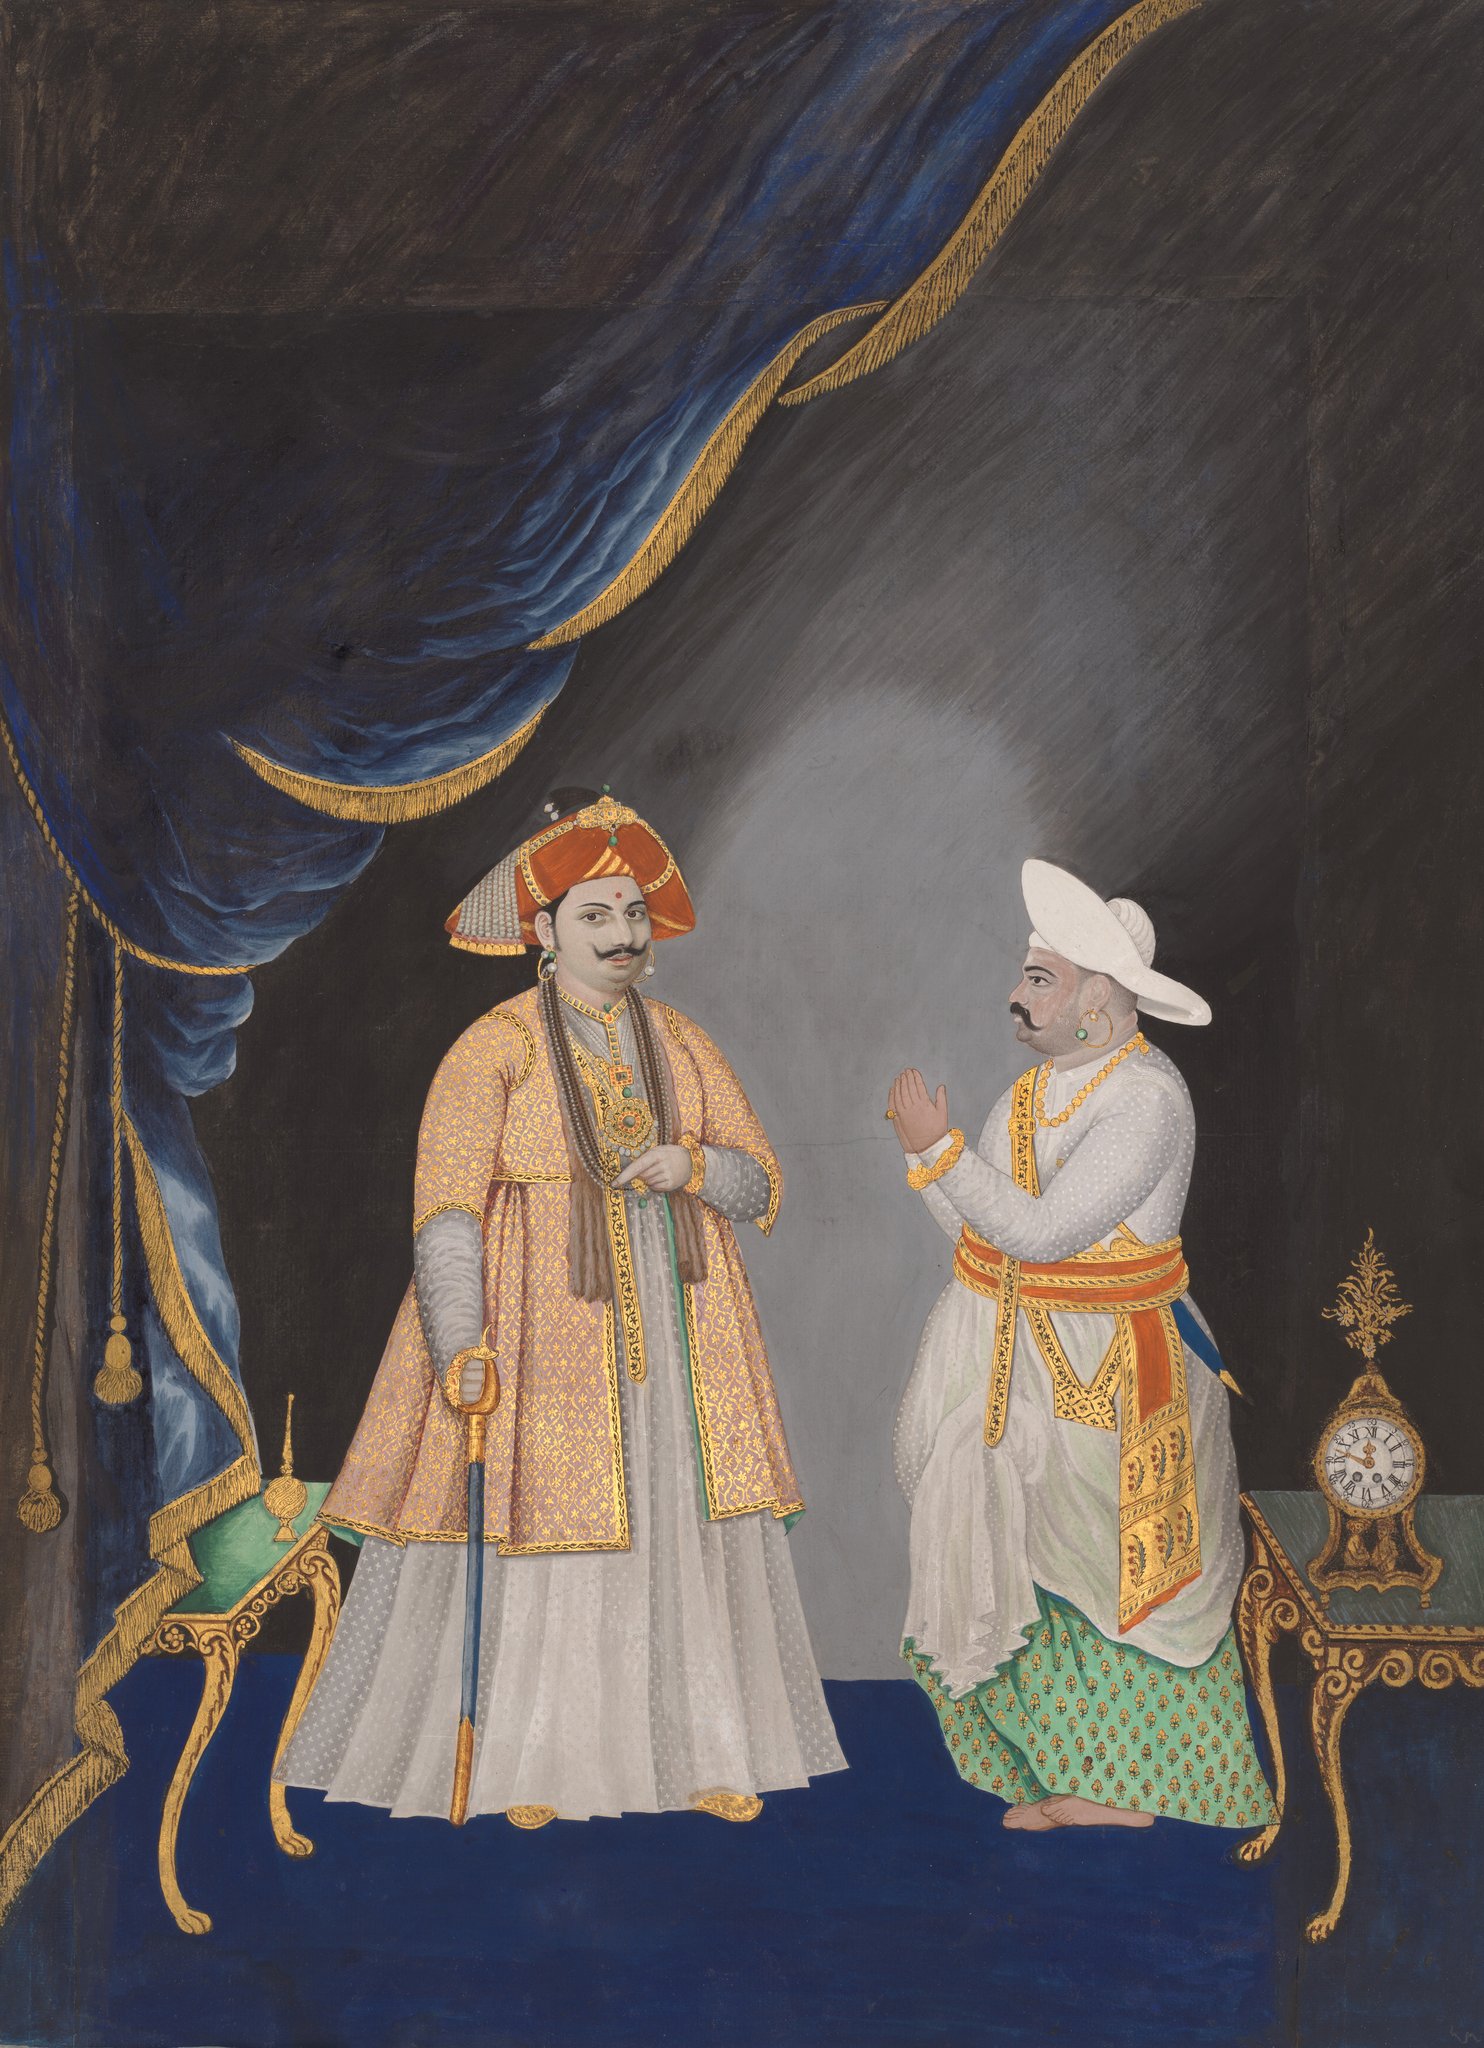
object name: painting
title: Maharaja Serfoji II accompanied by his Minister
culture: indian, thanjavur, tamil nadu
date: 1800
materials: gold, paper, watercolor